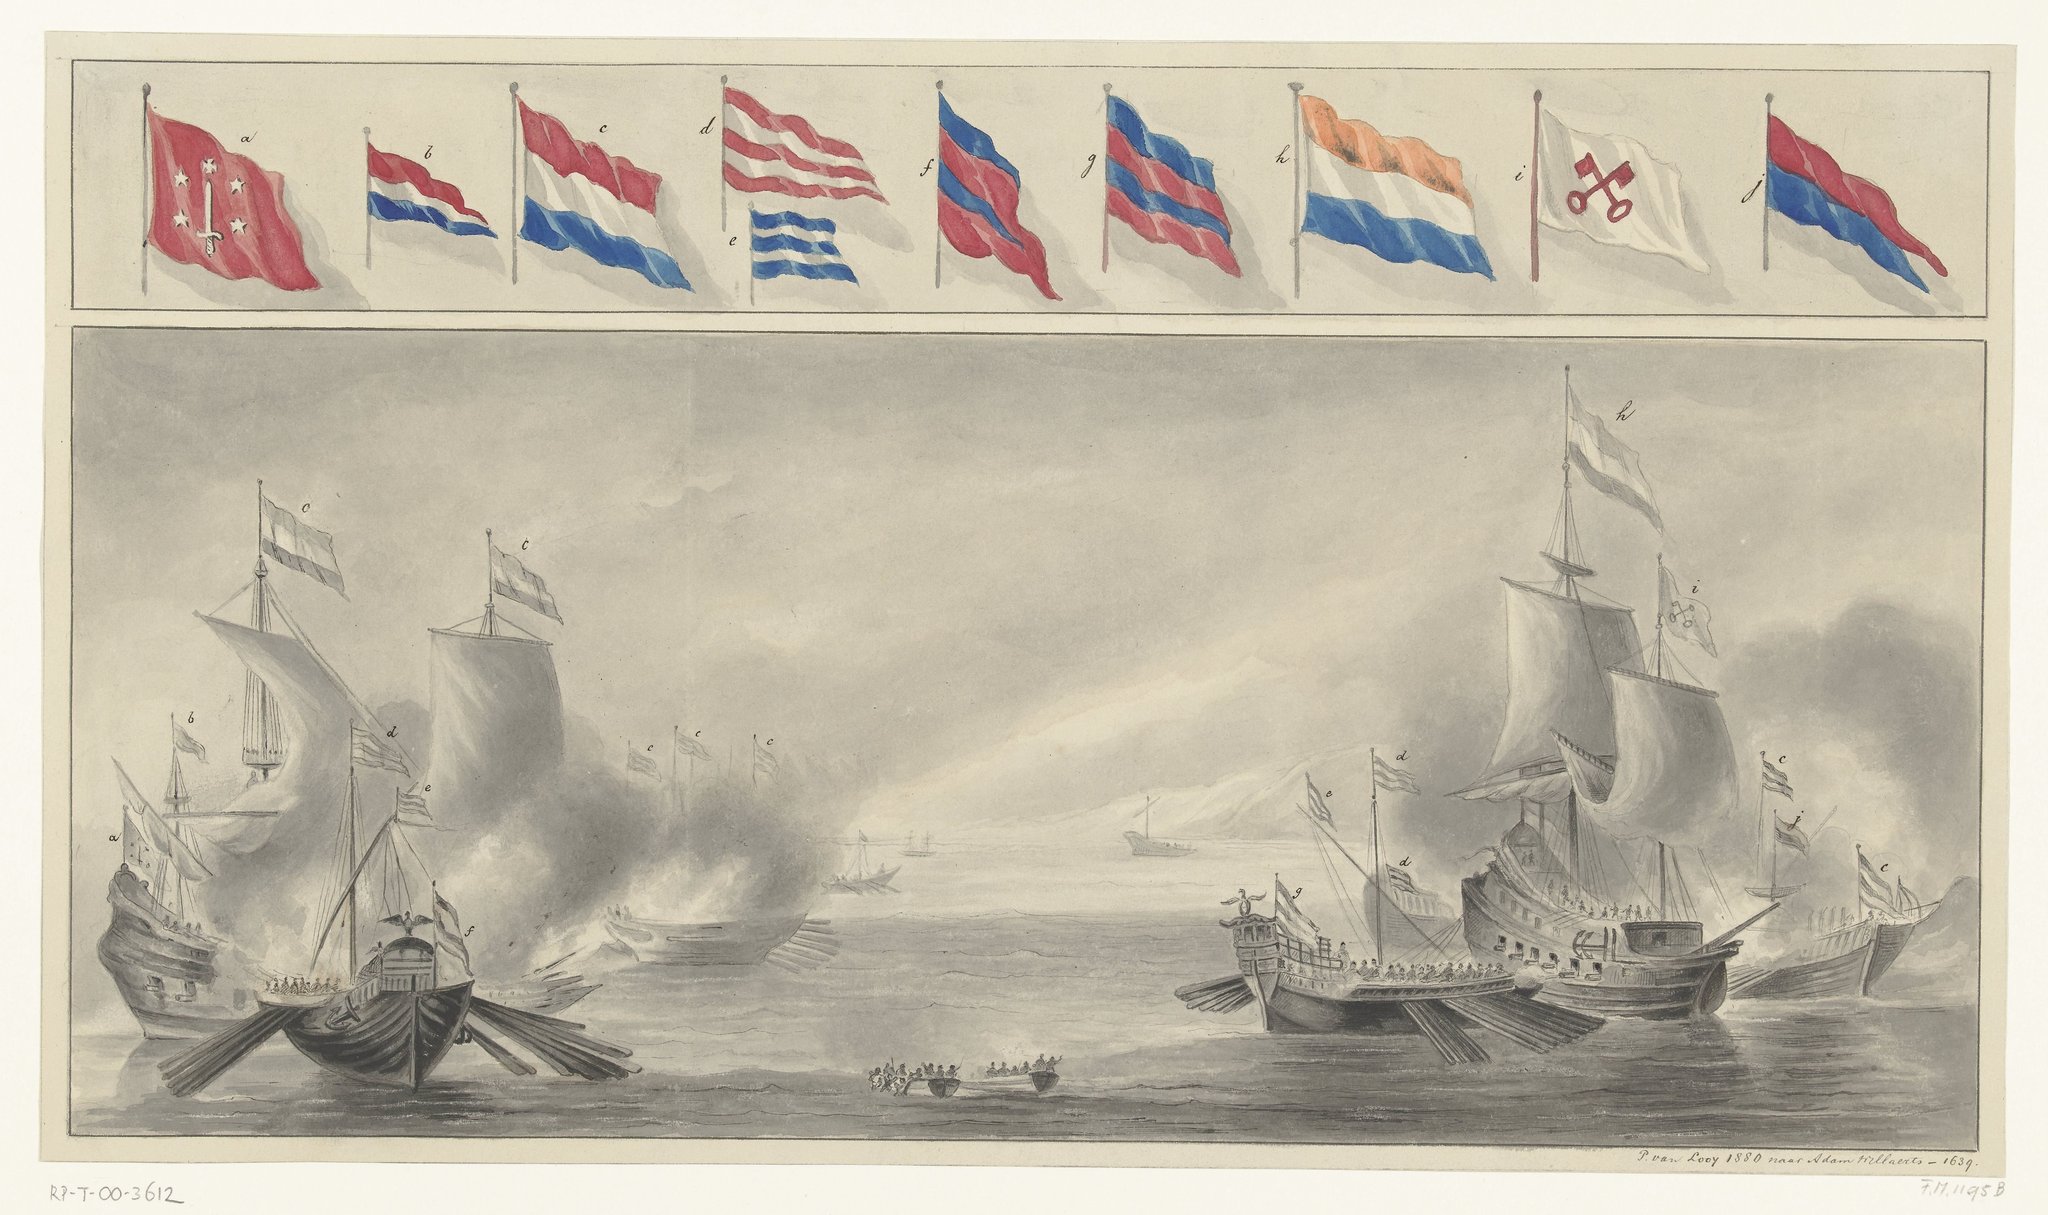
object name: historieplaat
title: Zeeslag tussen Hollandse schepen en Spaanse galeien, 1602 of 1603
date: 1880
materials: paper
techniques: brush, pen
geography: netherlands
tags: battle (+ naval force), warfare; military affairs (+ oared ships, e.g.: galley), trireme, galley, leiden, haarlem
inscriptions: date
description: Zeeslag tussen Hollandse schepen en Spaanse galeien, 1602 of 1603. Voorstelling de zeeslag tussen het Staatse eskader onder leiding van vice-admiraal Jacob van Duivenvoorde, heer van Obdam, en de Spaanse galeien in het Kanaal op 3 oktober 1602, of van de zeeslag voor de kust bij Sluis waarbij de acht Spaanse galeien onder Federico Spinola worden verslagen door de Staatse vloot van drie schepen en twee galeien onder Joos de Moor, 26 mei 1603. Enkele van de galeien staan in brand. De vlaggen van schepen (waaronder Haarlem, Leiden) zijn aangeduid met letters en staan bovenaan in kleur afgebeeld.